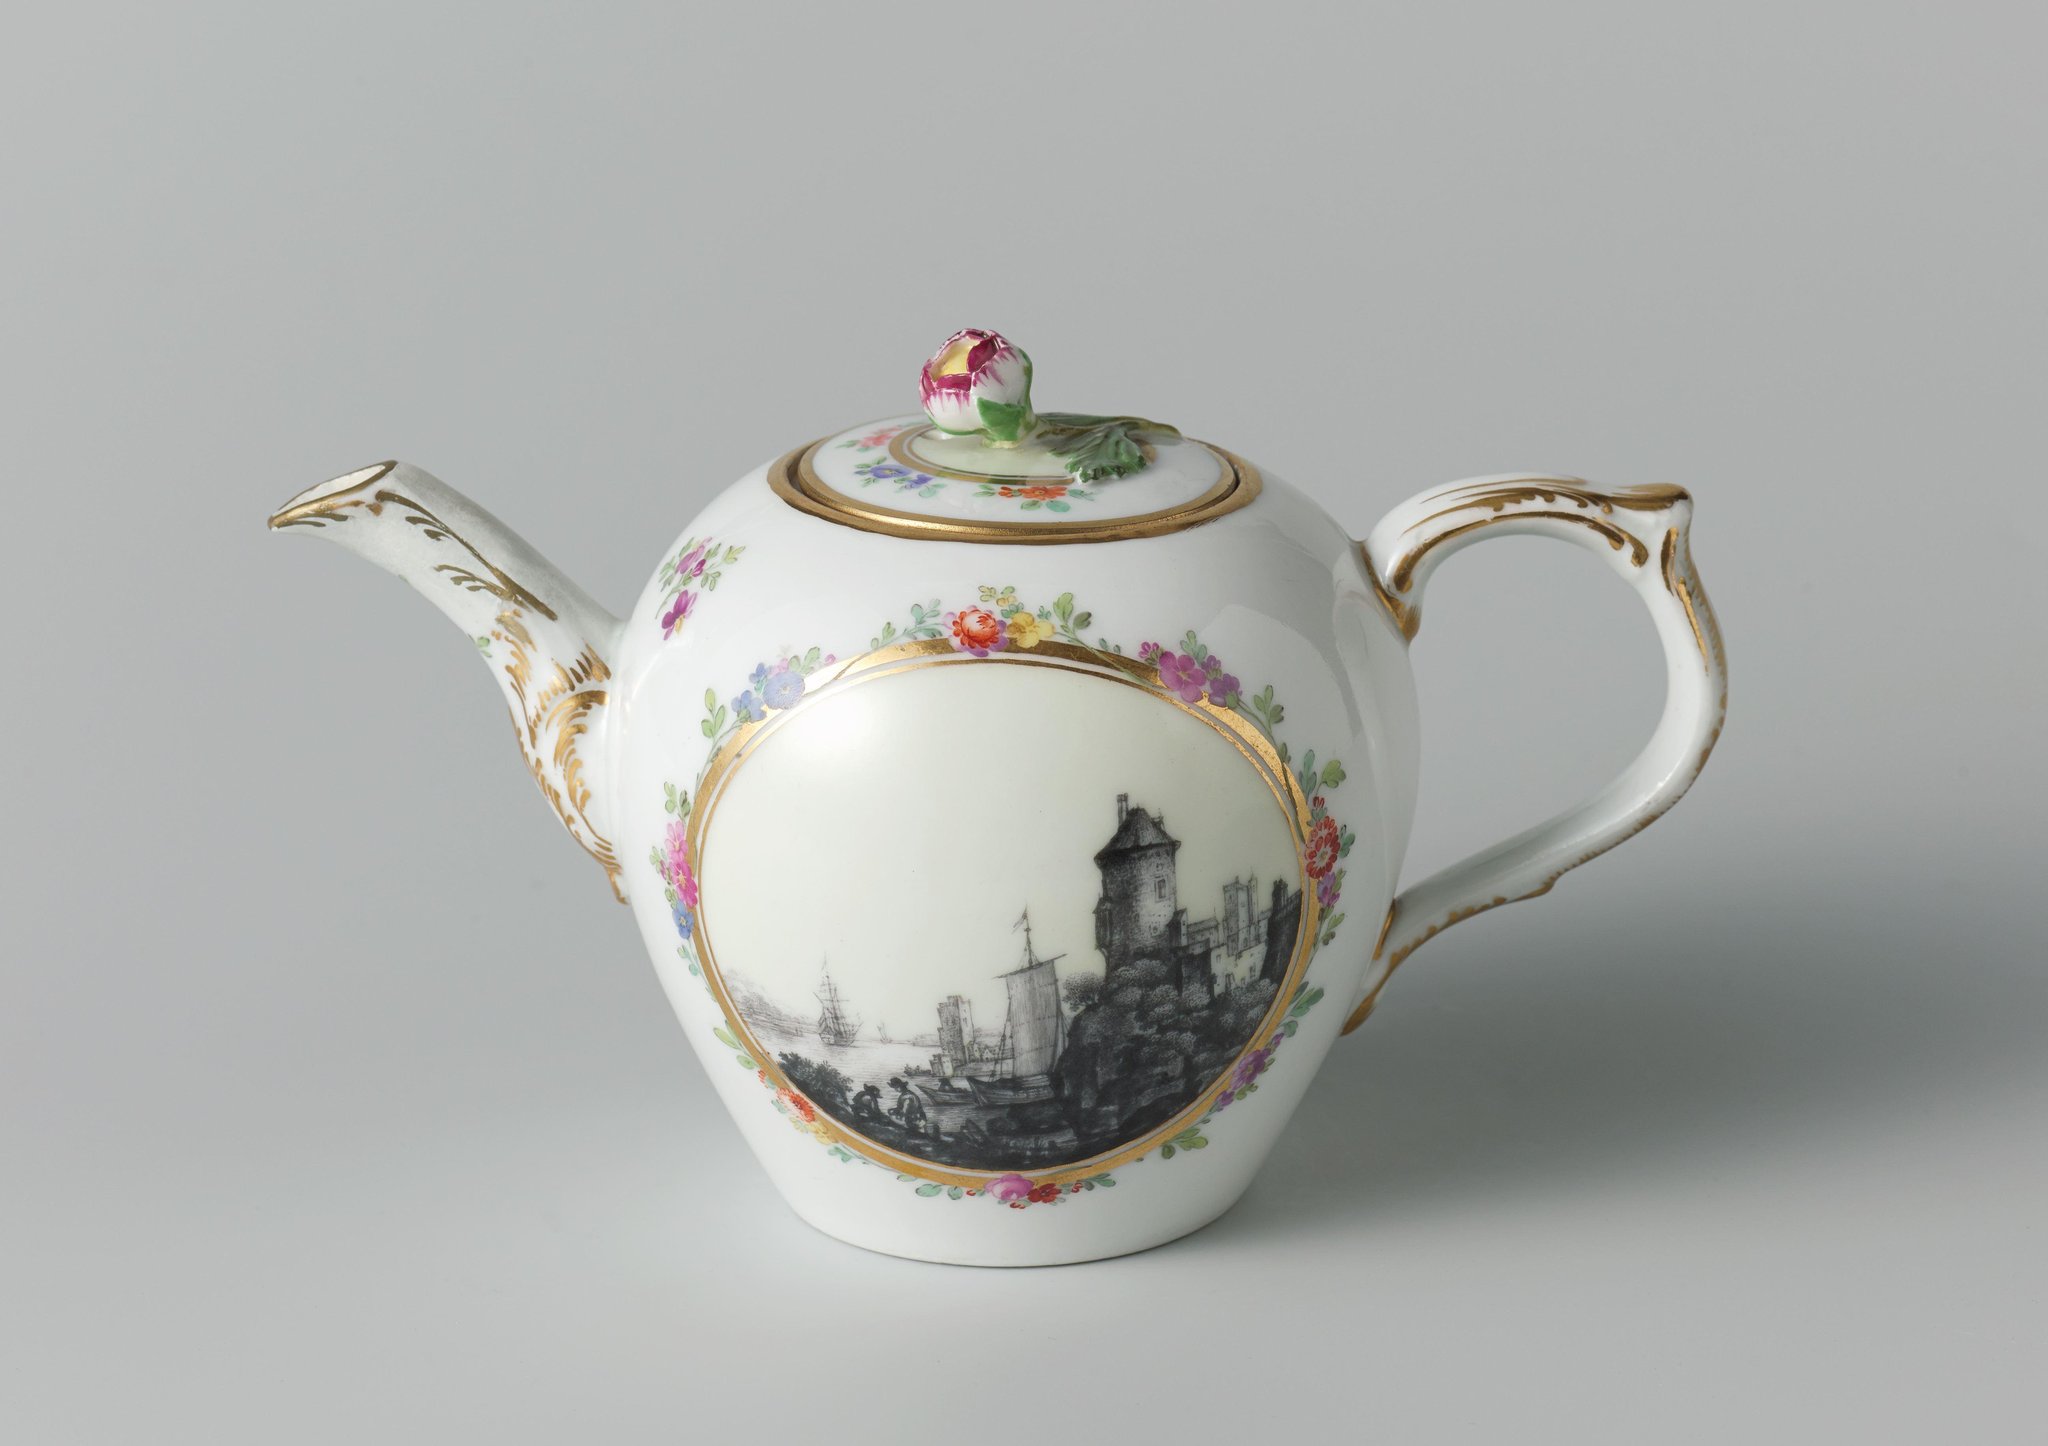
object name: teapot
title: Teapot with a landscape and flower sprays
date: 1780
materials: glaze, gold, paint, porcelain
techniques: firing, forming, gilding, turning, vitrification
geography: berlin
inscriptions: mark: ‘scepter/ II’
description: Theepot van porselein met een eivormig lichaam, C-vormig oor en licht gebogen tuit. Beschilderd in emailkleuren en goud. Op de buik tweemaal een medaillon van bloemtakken met daarin een landschap. Het oor en de tuit zijn versierd in rocaillestijl. Gemerkt op de onderzijde met de scepter en II.